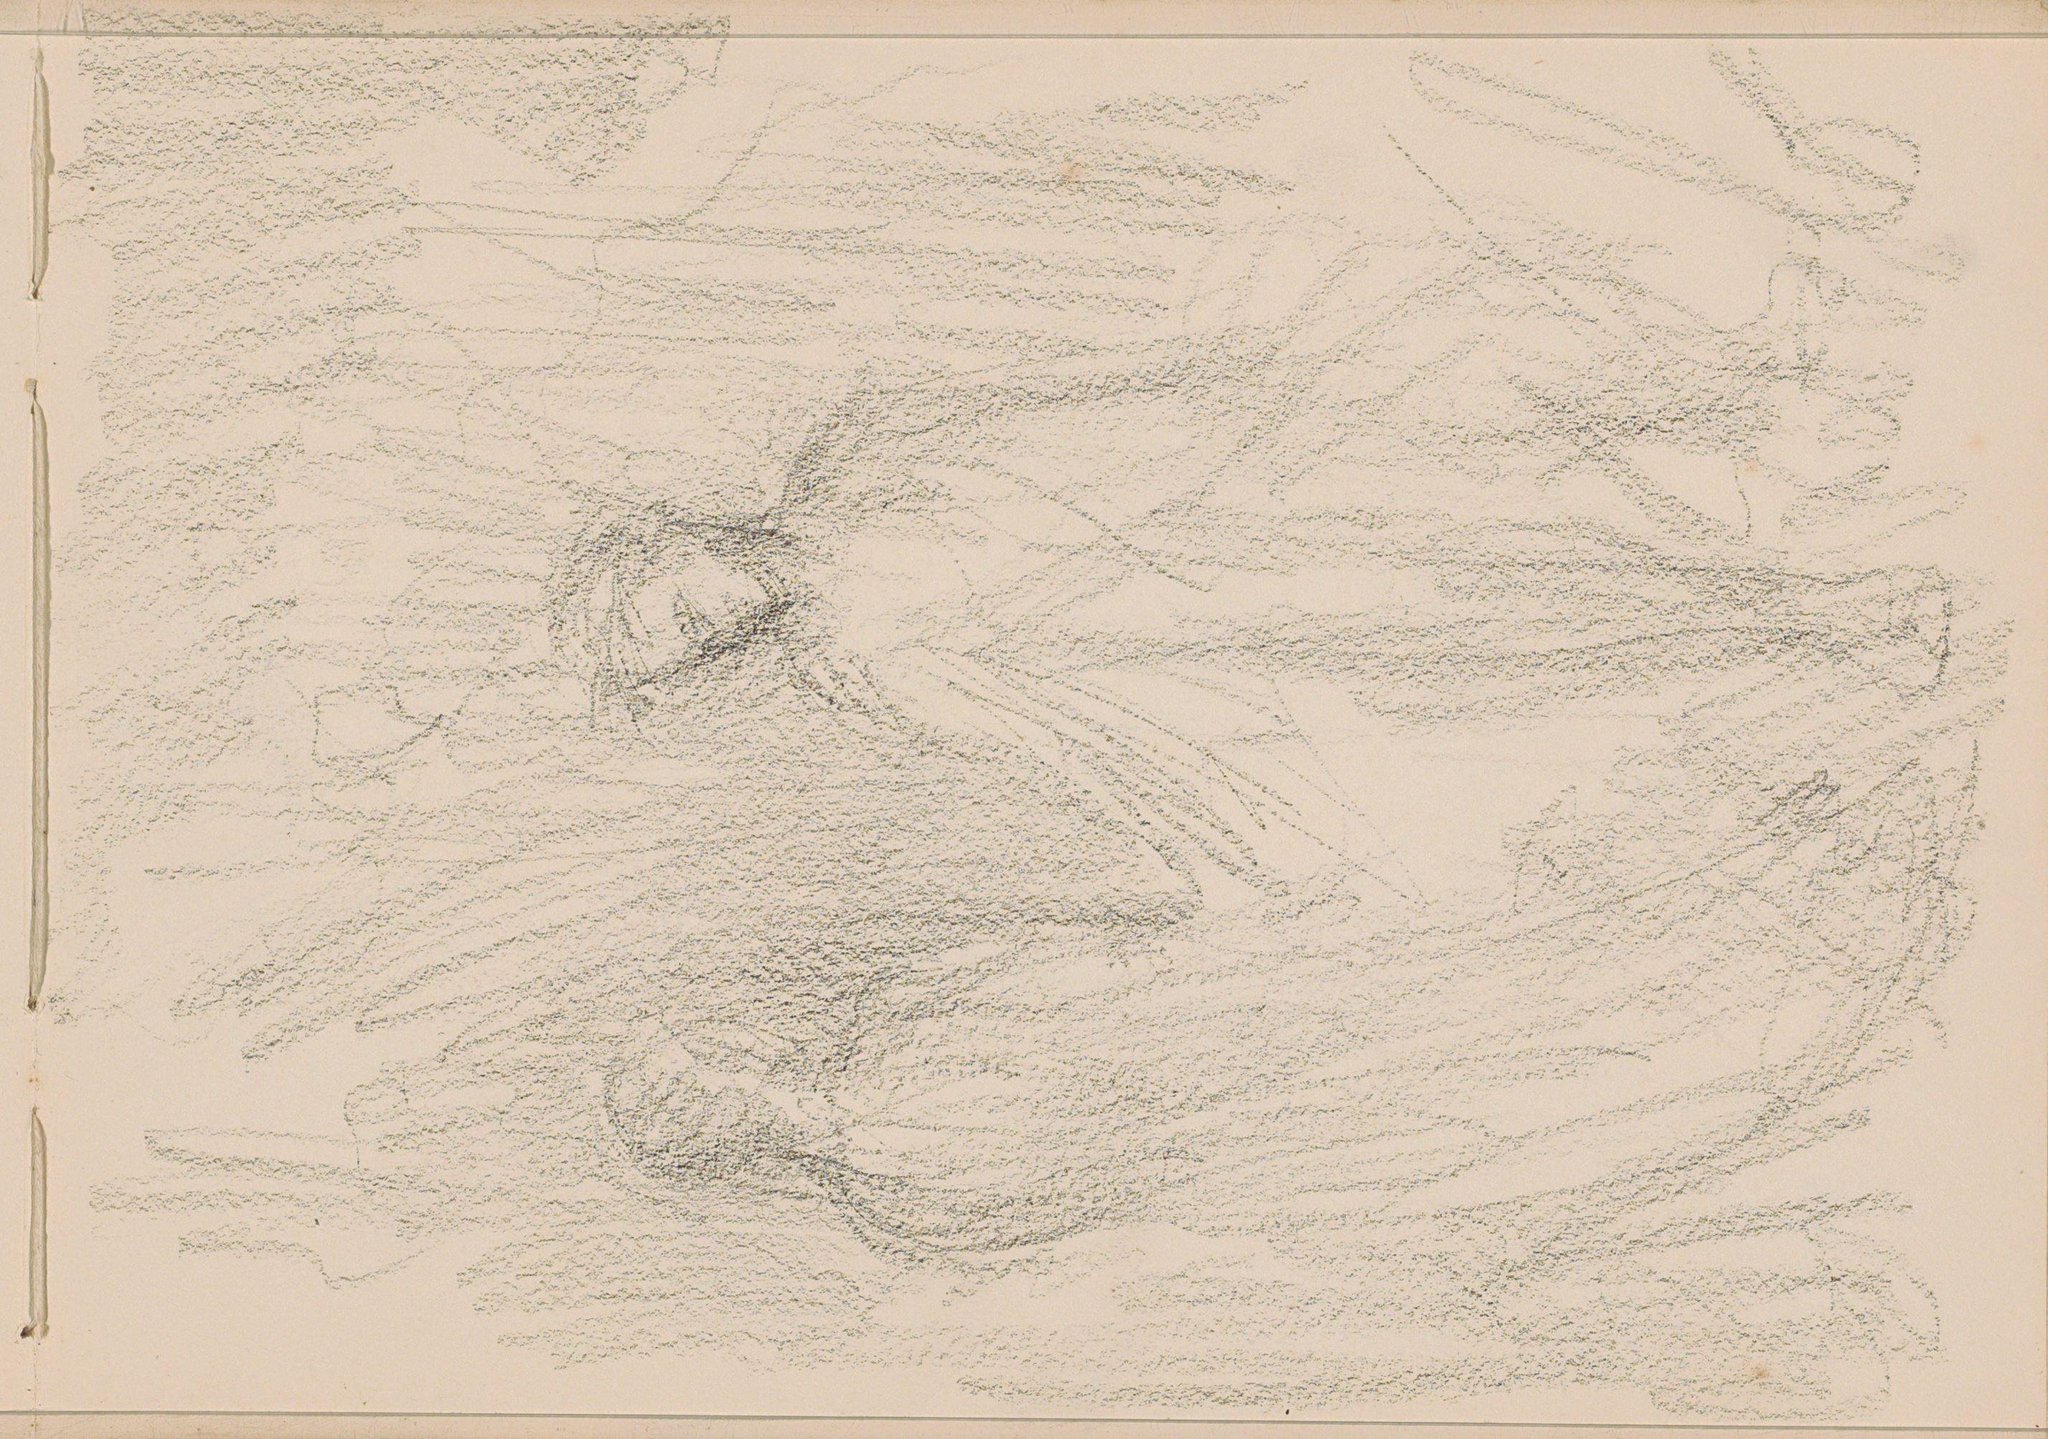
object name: sketchbook leaf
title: Twee figuren, waarvan één een hand naar de ander uitsteekt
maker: a.a.l. de grammont-hubrecht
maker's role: draughtsman, painter, print maker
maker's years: 1855-1913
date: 1865-1913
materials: chalk, paper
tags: leading someone by the hand or wrist - aa - both arms or hands, anatomy (non-medical)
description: Blad 19 recto uit een schetsboek met 68 bladen.